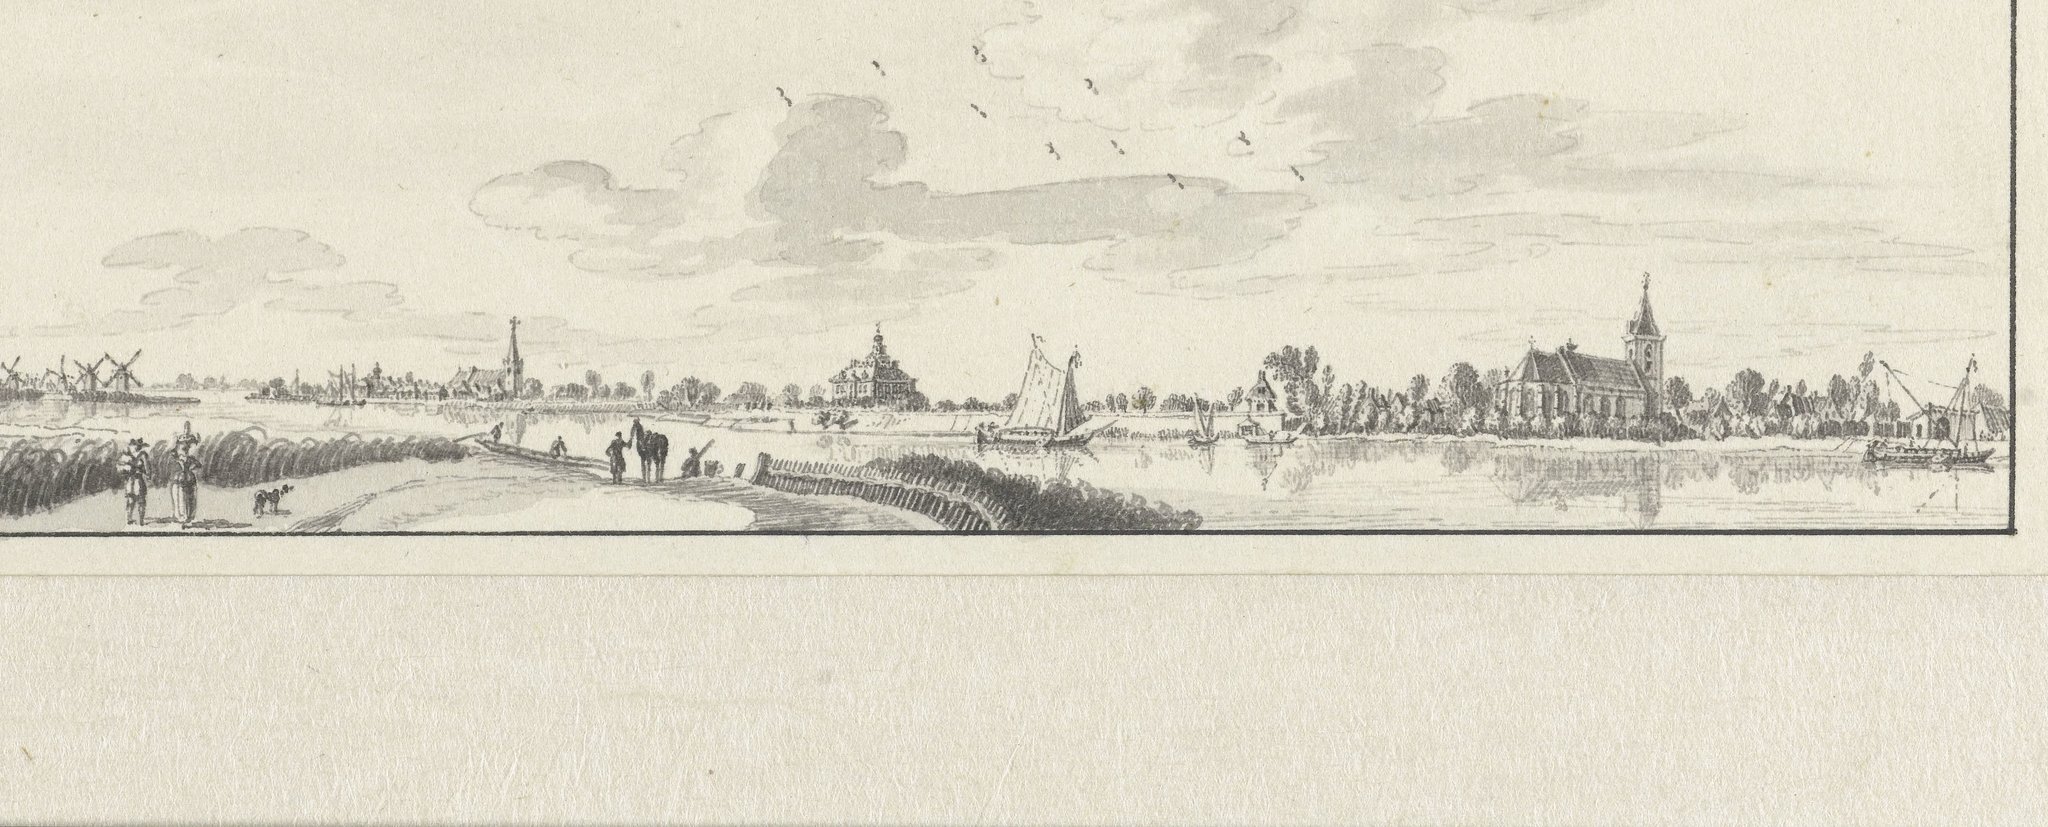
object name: drawing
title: Gezicht over de Lek op Ameide, het Huis Herlaer en Tienhoven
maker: jan de beijer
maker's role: draughtsman, print maker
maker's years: 1703-1780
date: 1745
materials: ink, paper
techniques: brush, pen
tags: castle, river